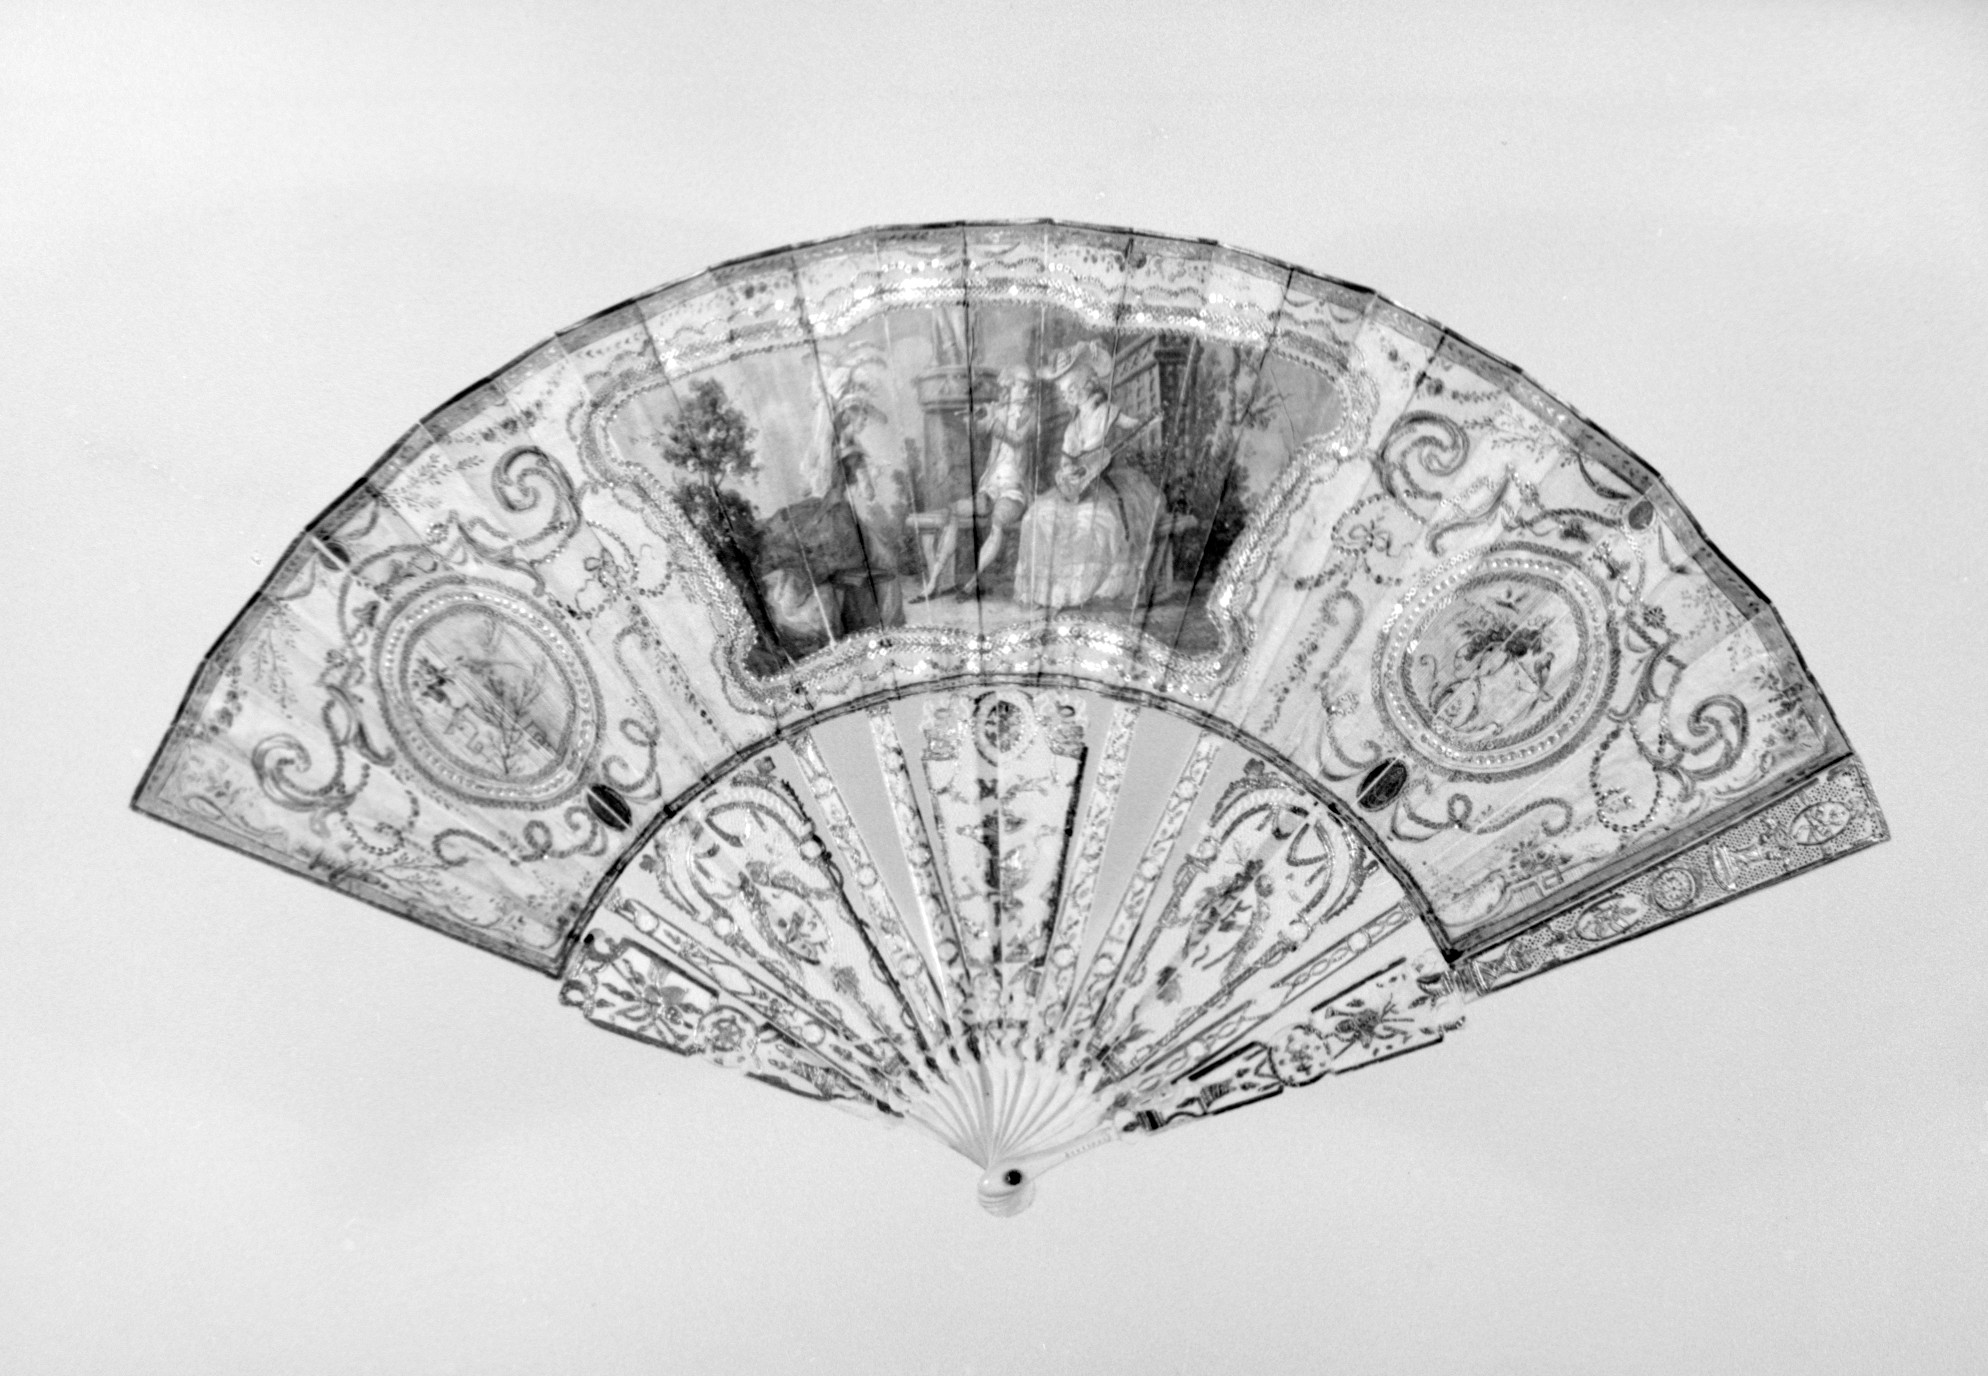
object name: fan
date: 1701-1800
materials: foil, glass, gold, ivory, metal thread, silk, silver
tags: men,women,flutes